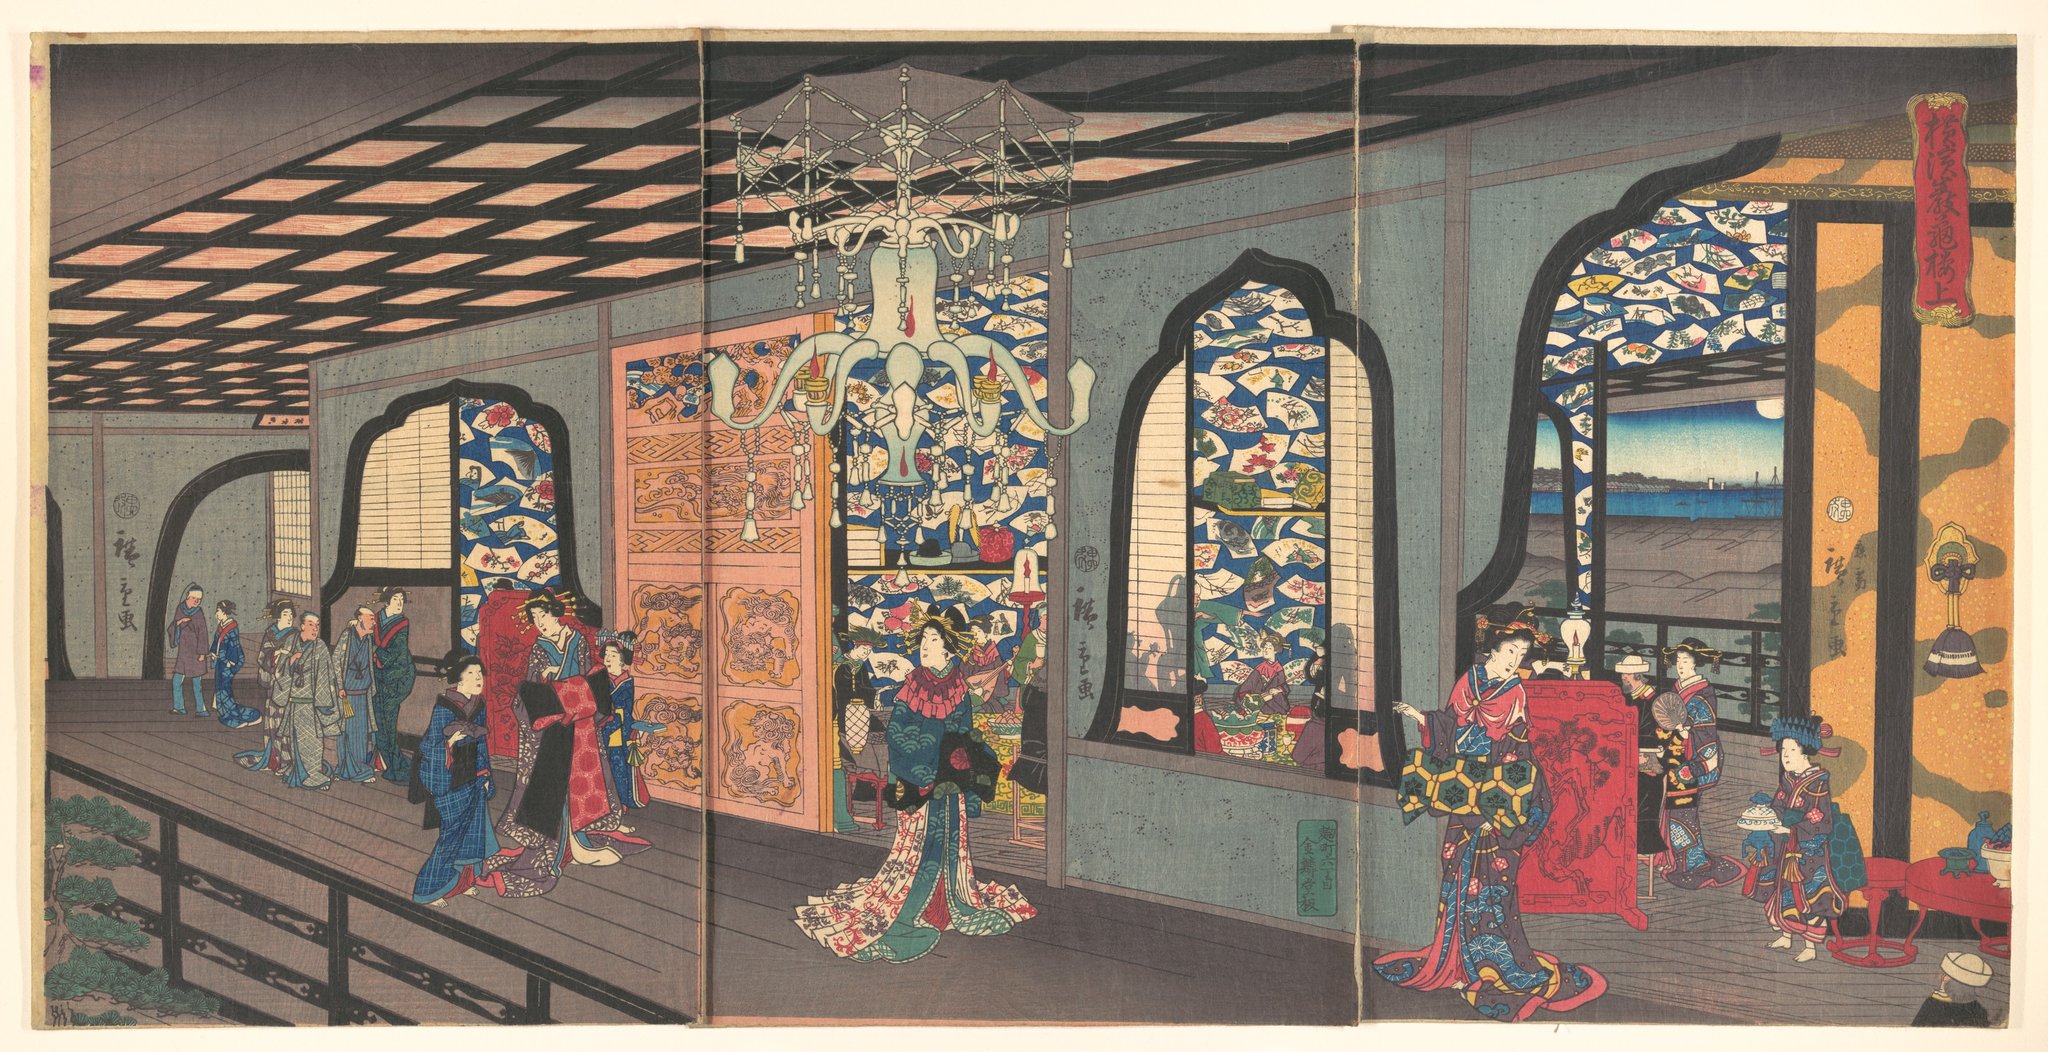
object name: print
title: Upper Floor of the Gankirō Tea House in Yokohama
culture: japanese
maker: utagawa hiroshige ii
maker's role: artist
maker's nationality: japanese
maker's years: 1826-1869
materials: ink, paper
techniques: woodblock print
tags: interiors,men,women